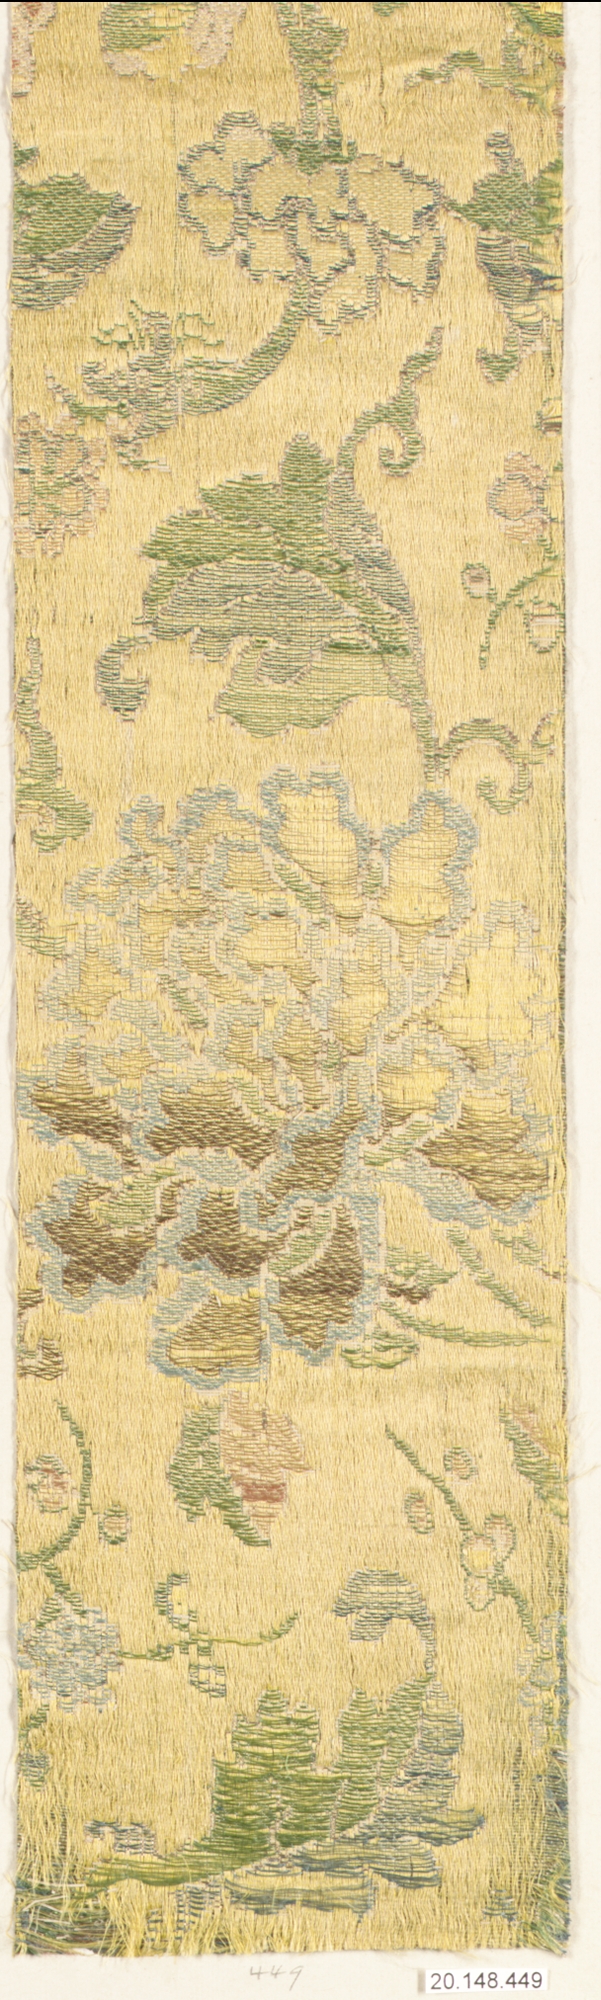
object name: piece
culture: chinese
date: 1601-1700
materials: silk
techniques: compound weave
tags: flowers,leaves